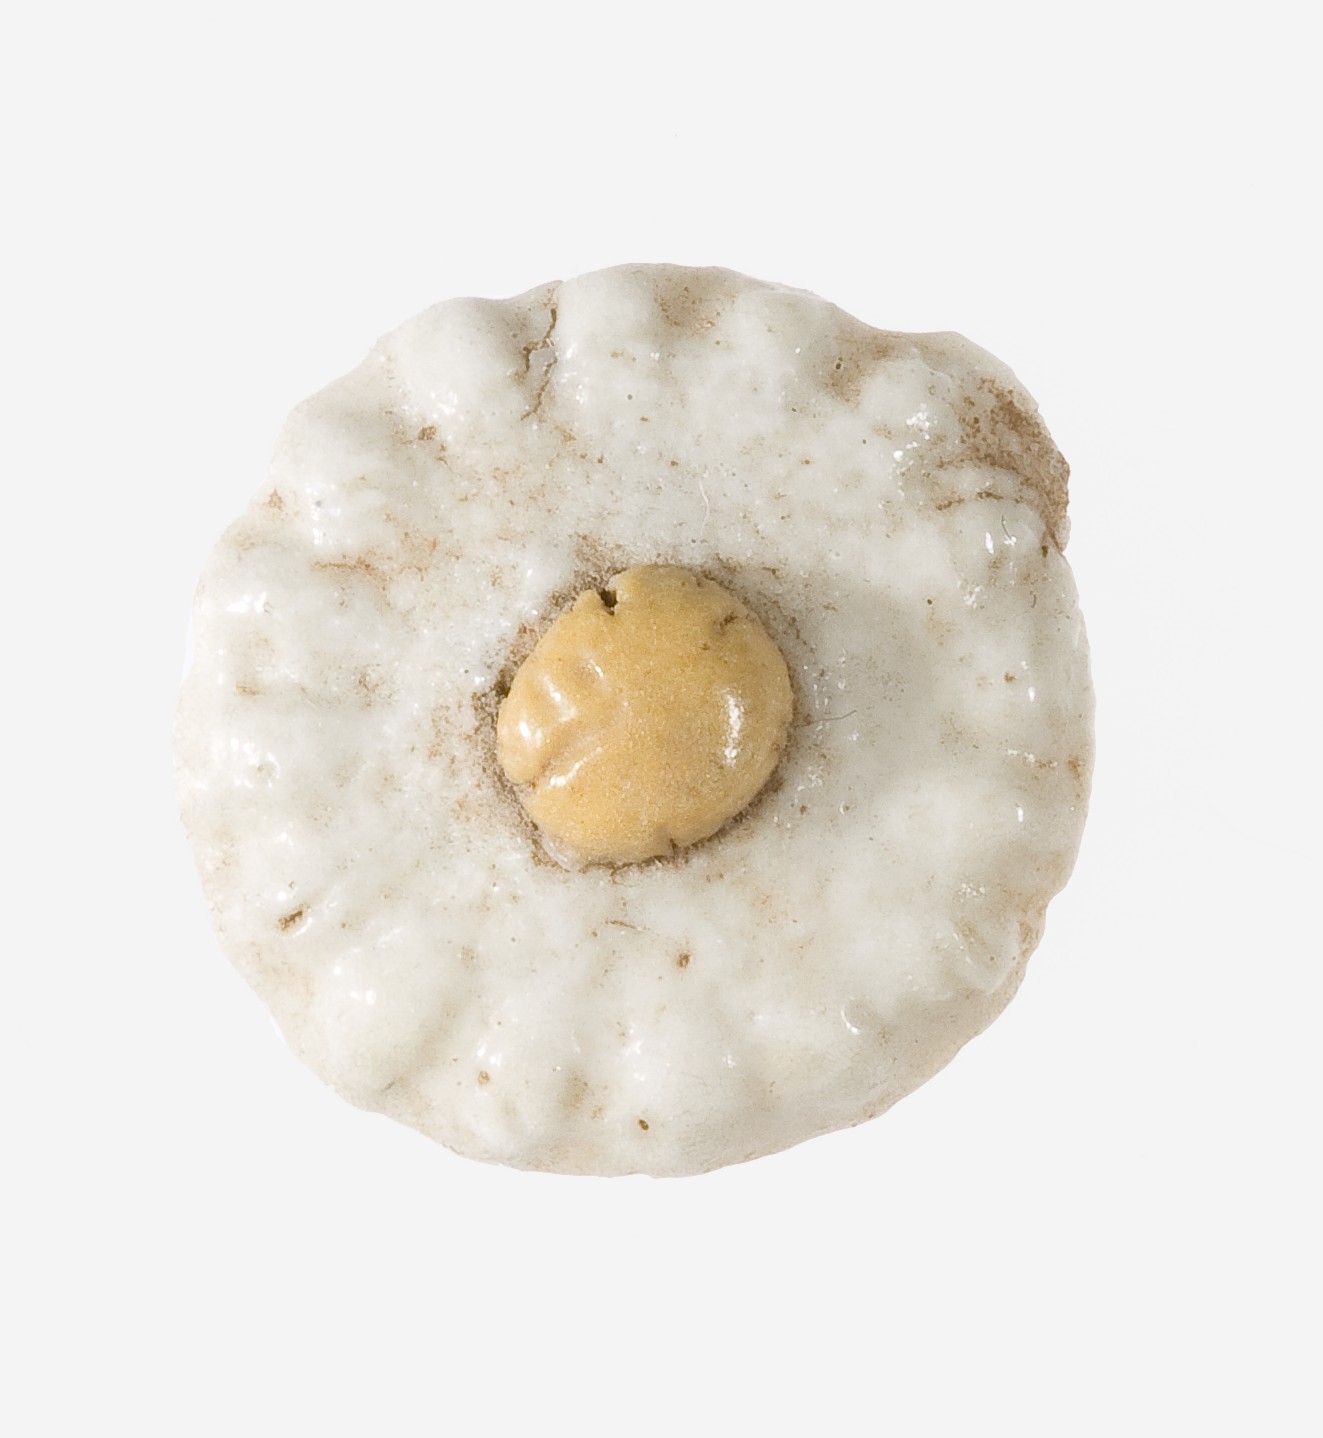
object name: pendant, daisy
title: Daisy Pendant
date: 1390-1352 BCE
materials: faience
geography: egypt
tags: daisies